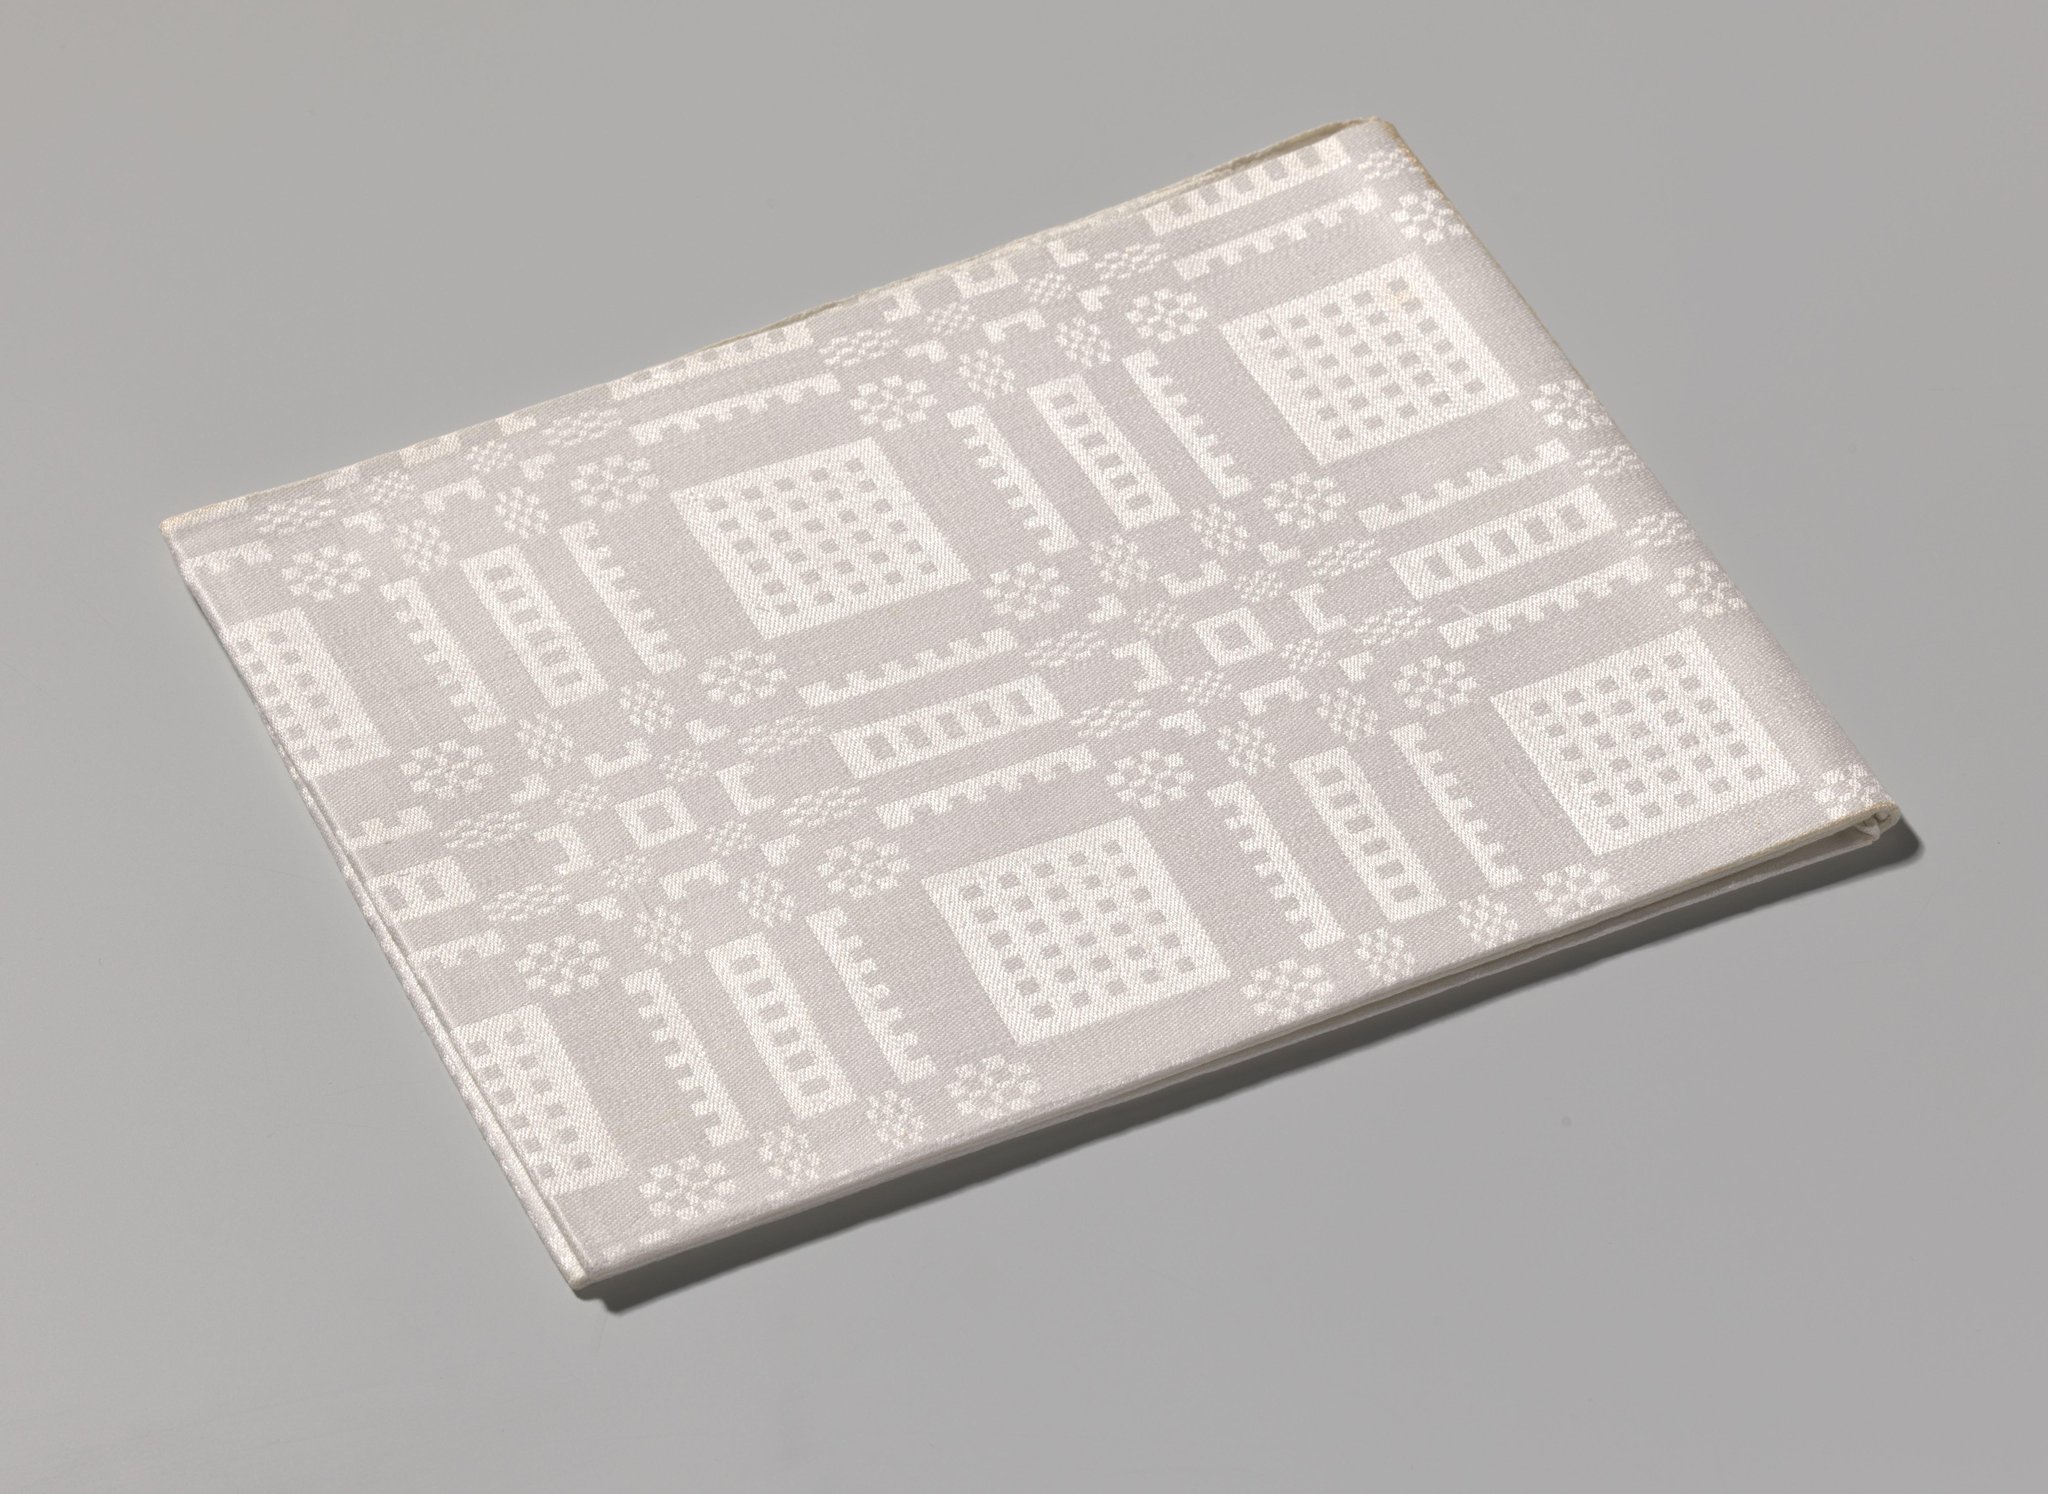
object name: napkin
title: Servet met pellenpatroon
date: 1756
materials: linen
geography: northern netherlands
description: Servet van wit linnen met pellenpatroon, merk kroon G 30 en 1756.